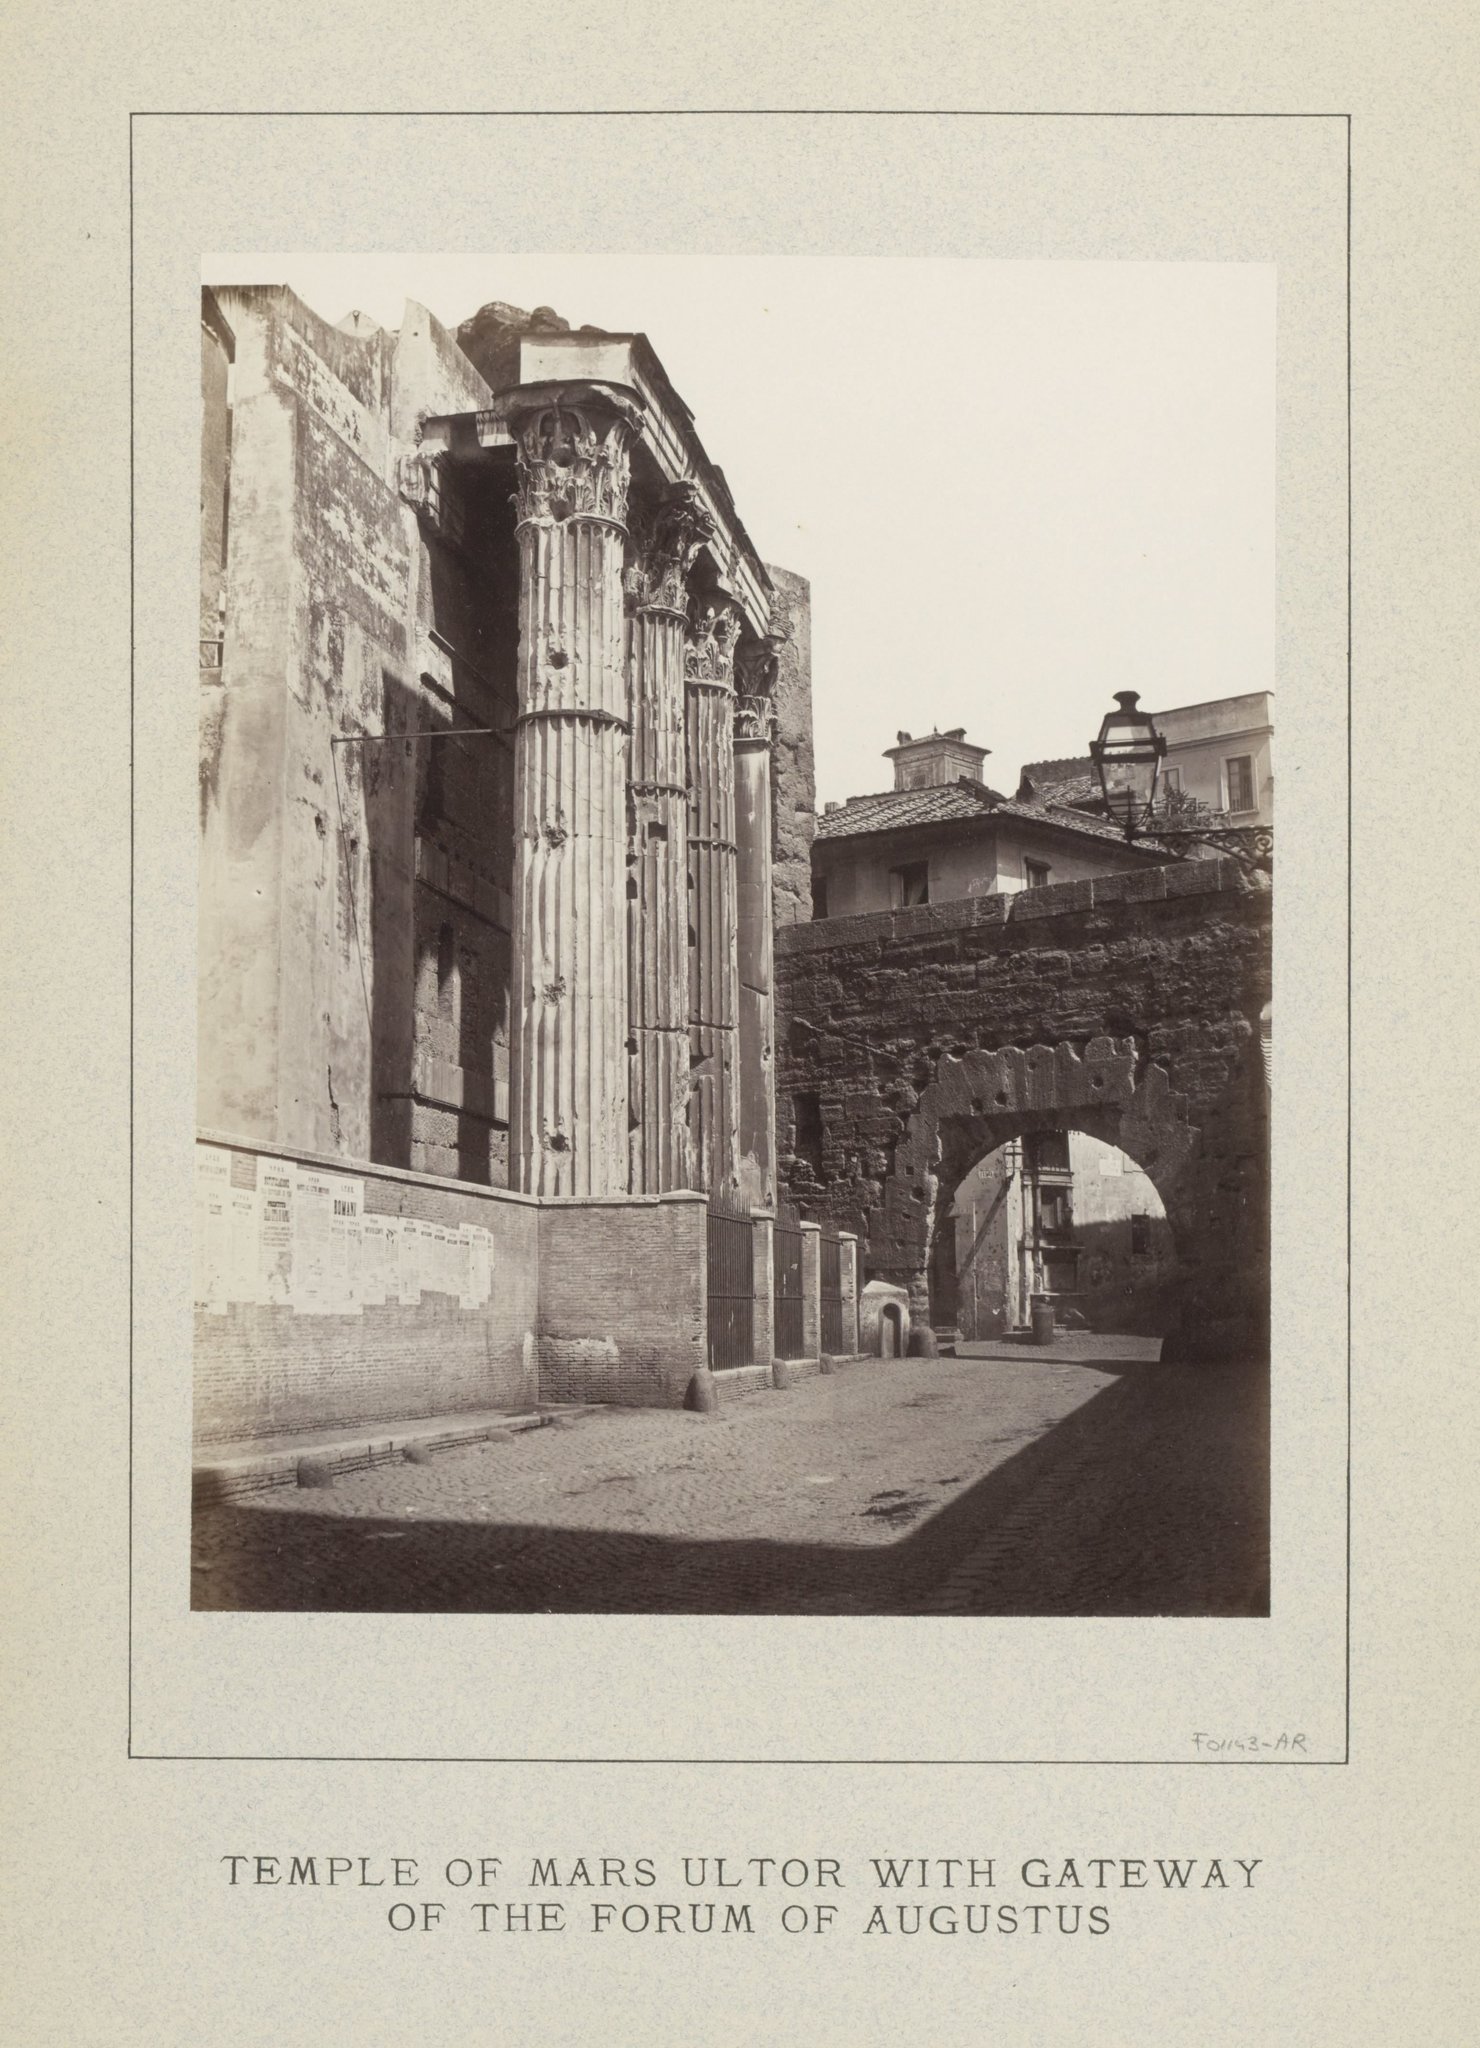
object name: photograph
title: Temple of Mars Ultor with gateway of the Forum of Augustus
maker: Anonymous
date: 1860-1900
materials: photographic support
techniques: albumen print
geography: rome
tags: gate, entrance, temple, shrine ~ roman religion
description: Onderdeel van Fotoalbum met opnames van bezienswaardigheden en kunstwerken in Rome.